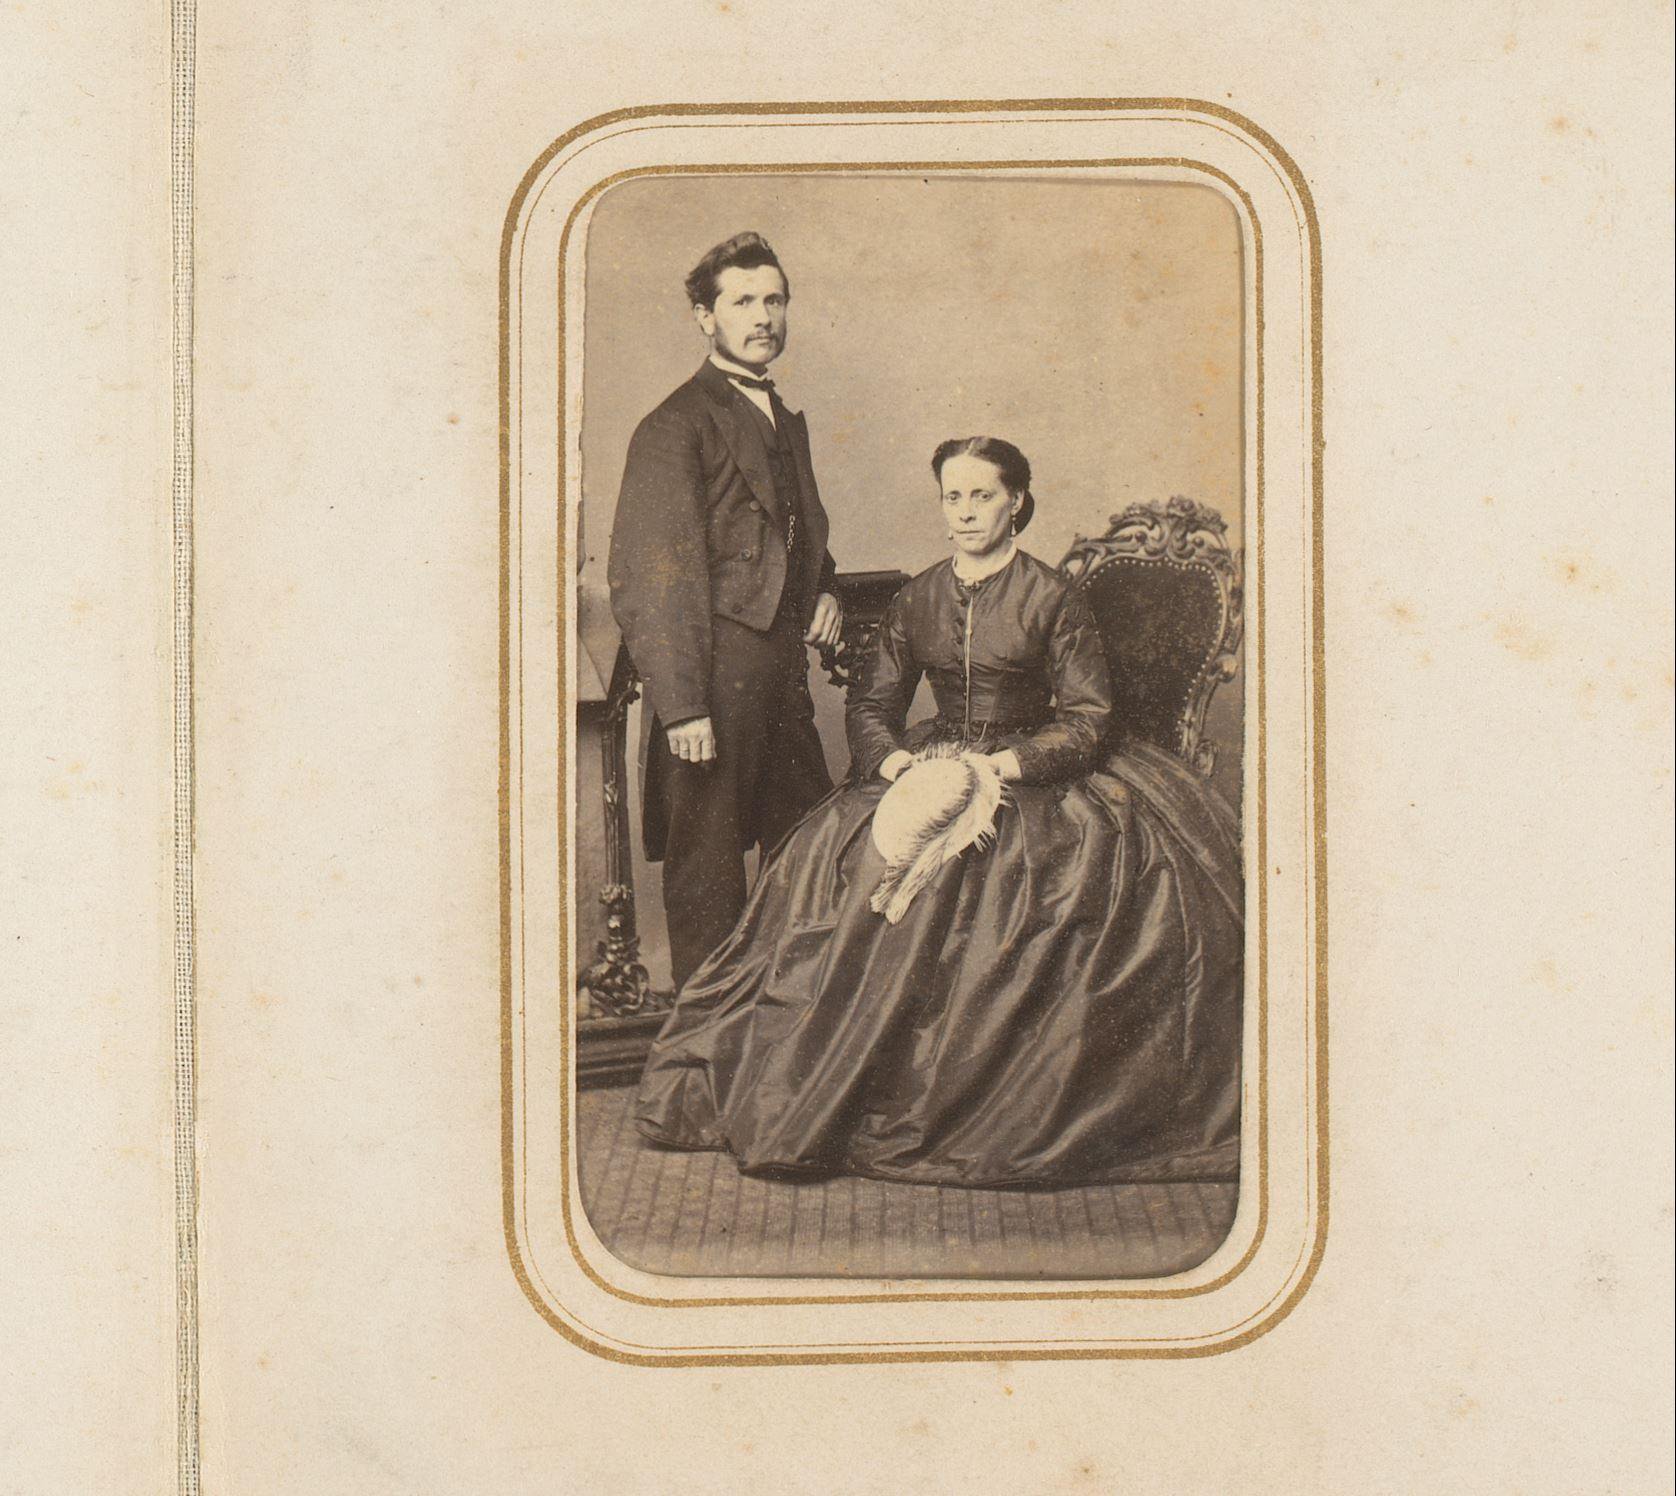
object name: carte de visite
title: Portret van een man en een zittende vrouw met hoed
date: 1876-1879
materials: cardboard, photographic support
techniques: albumen print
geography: breda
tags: sitting figure - aa - female human figure, historical persons - bb - woman, historical persons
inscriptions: inscription: ‘Kannemans en Zoon/ Artiste Photographen/ van/ Z.M. den Koning en H.M. de koningin/ Breda/ Groote Markt/ D. 15/ tegen over het stadhuis’